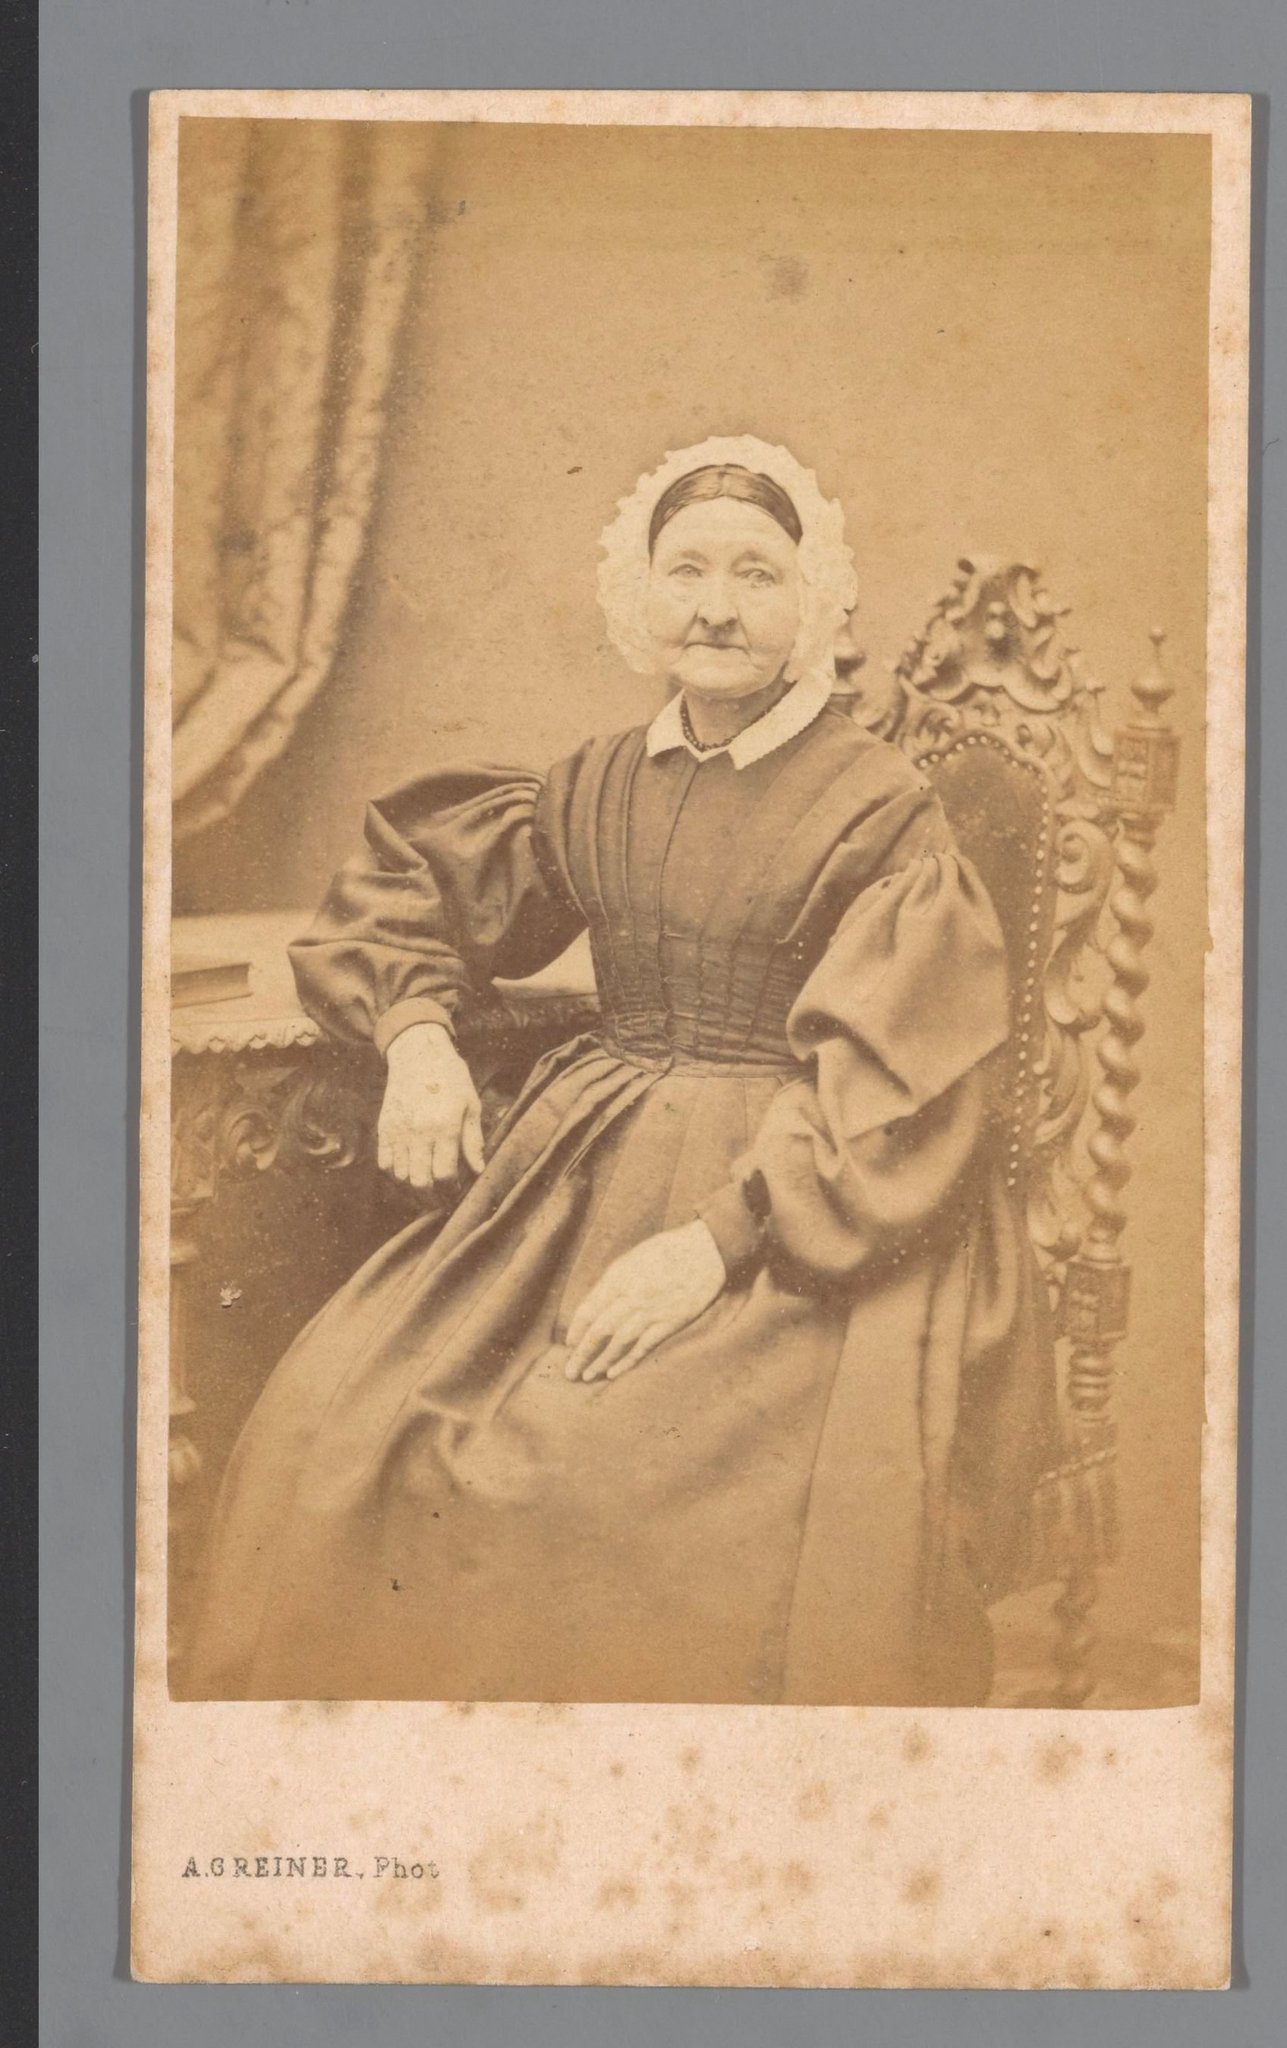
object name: carte de visite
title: Portret van een onbekende vrouw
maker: albert greiner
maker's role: fotograaf, fotostudio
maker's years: 1833-1890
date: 1862-1874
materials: cardboard, photographic support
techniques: albumen print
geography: netherlands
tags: historical persons not known by name - bb - woman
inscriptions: inscription: ‘A. GREINER / PHOTOGRAF / NIEUWENDIJK L.87 / AMSTERDAM’